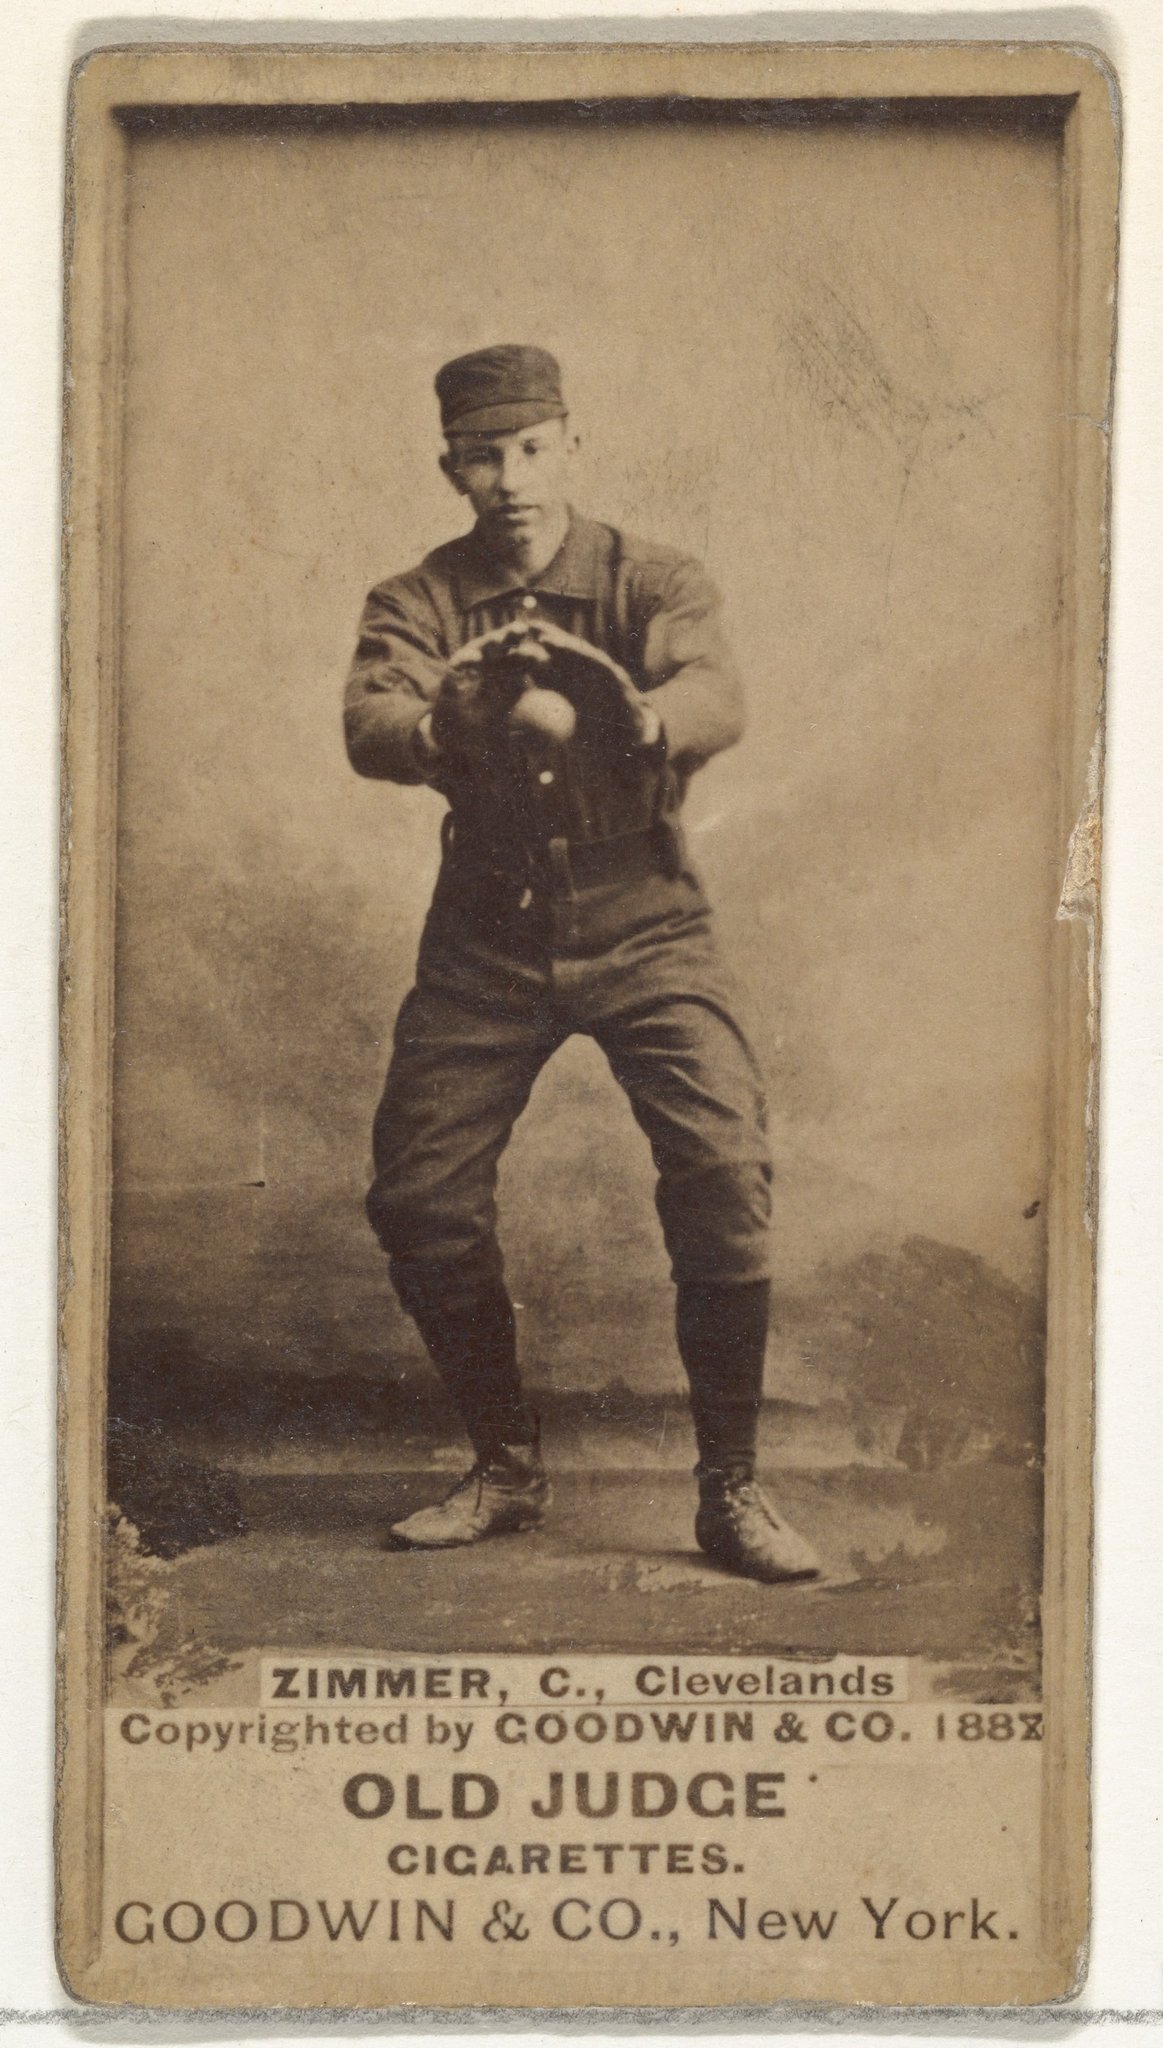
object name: baseball card, photograph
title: Charles Louis "Chief" Zimmer, Catcher, Cleveland, from the Old Judge series (N172) for Old Judge Cigarettes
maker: goodwin & company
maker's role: publisher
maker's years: 1850-1950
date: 1888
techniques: albumen silver print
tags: men,portraits,baseball,athletes